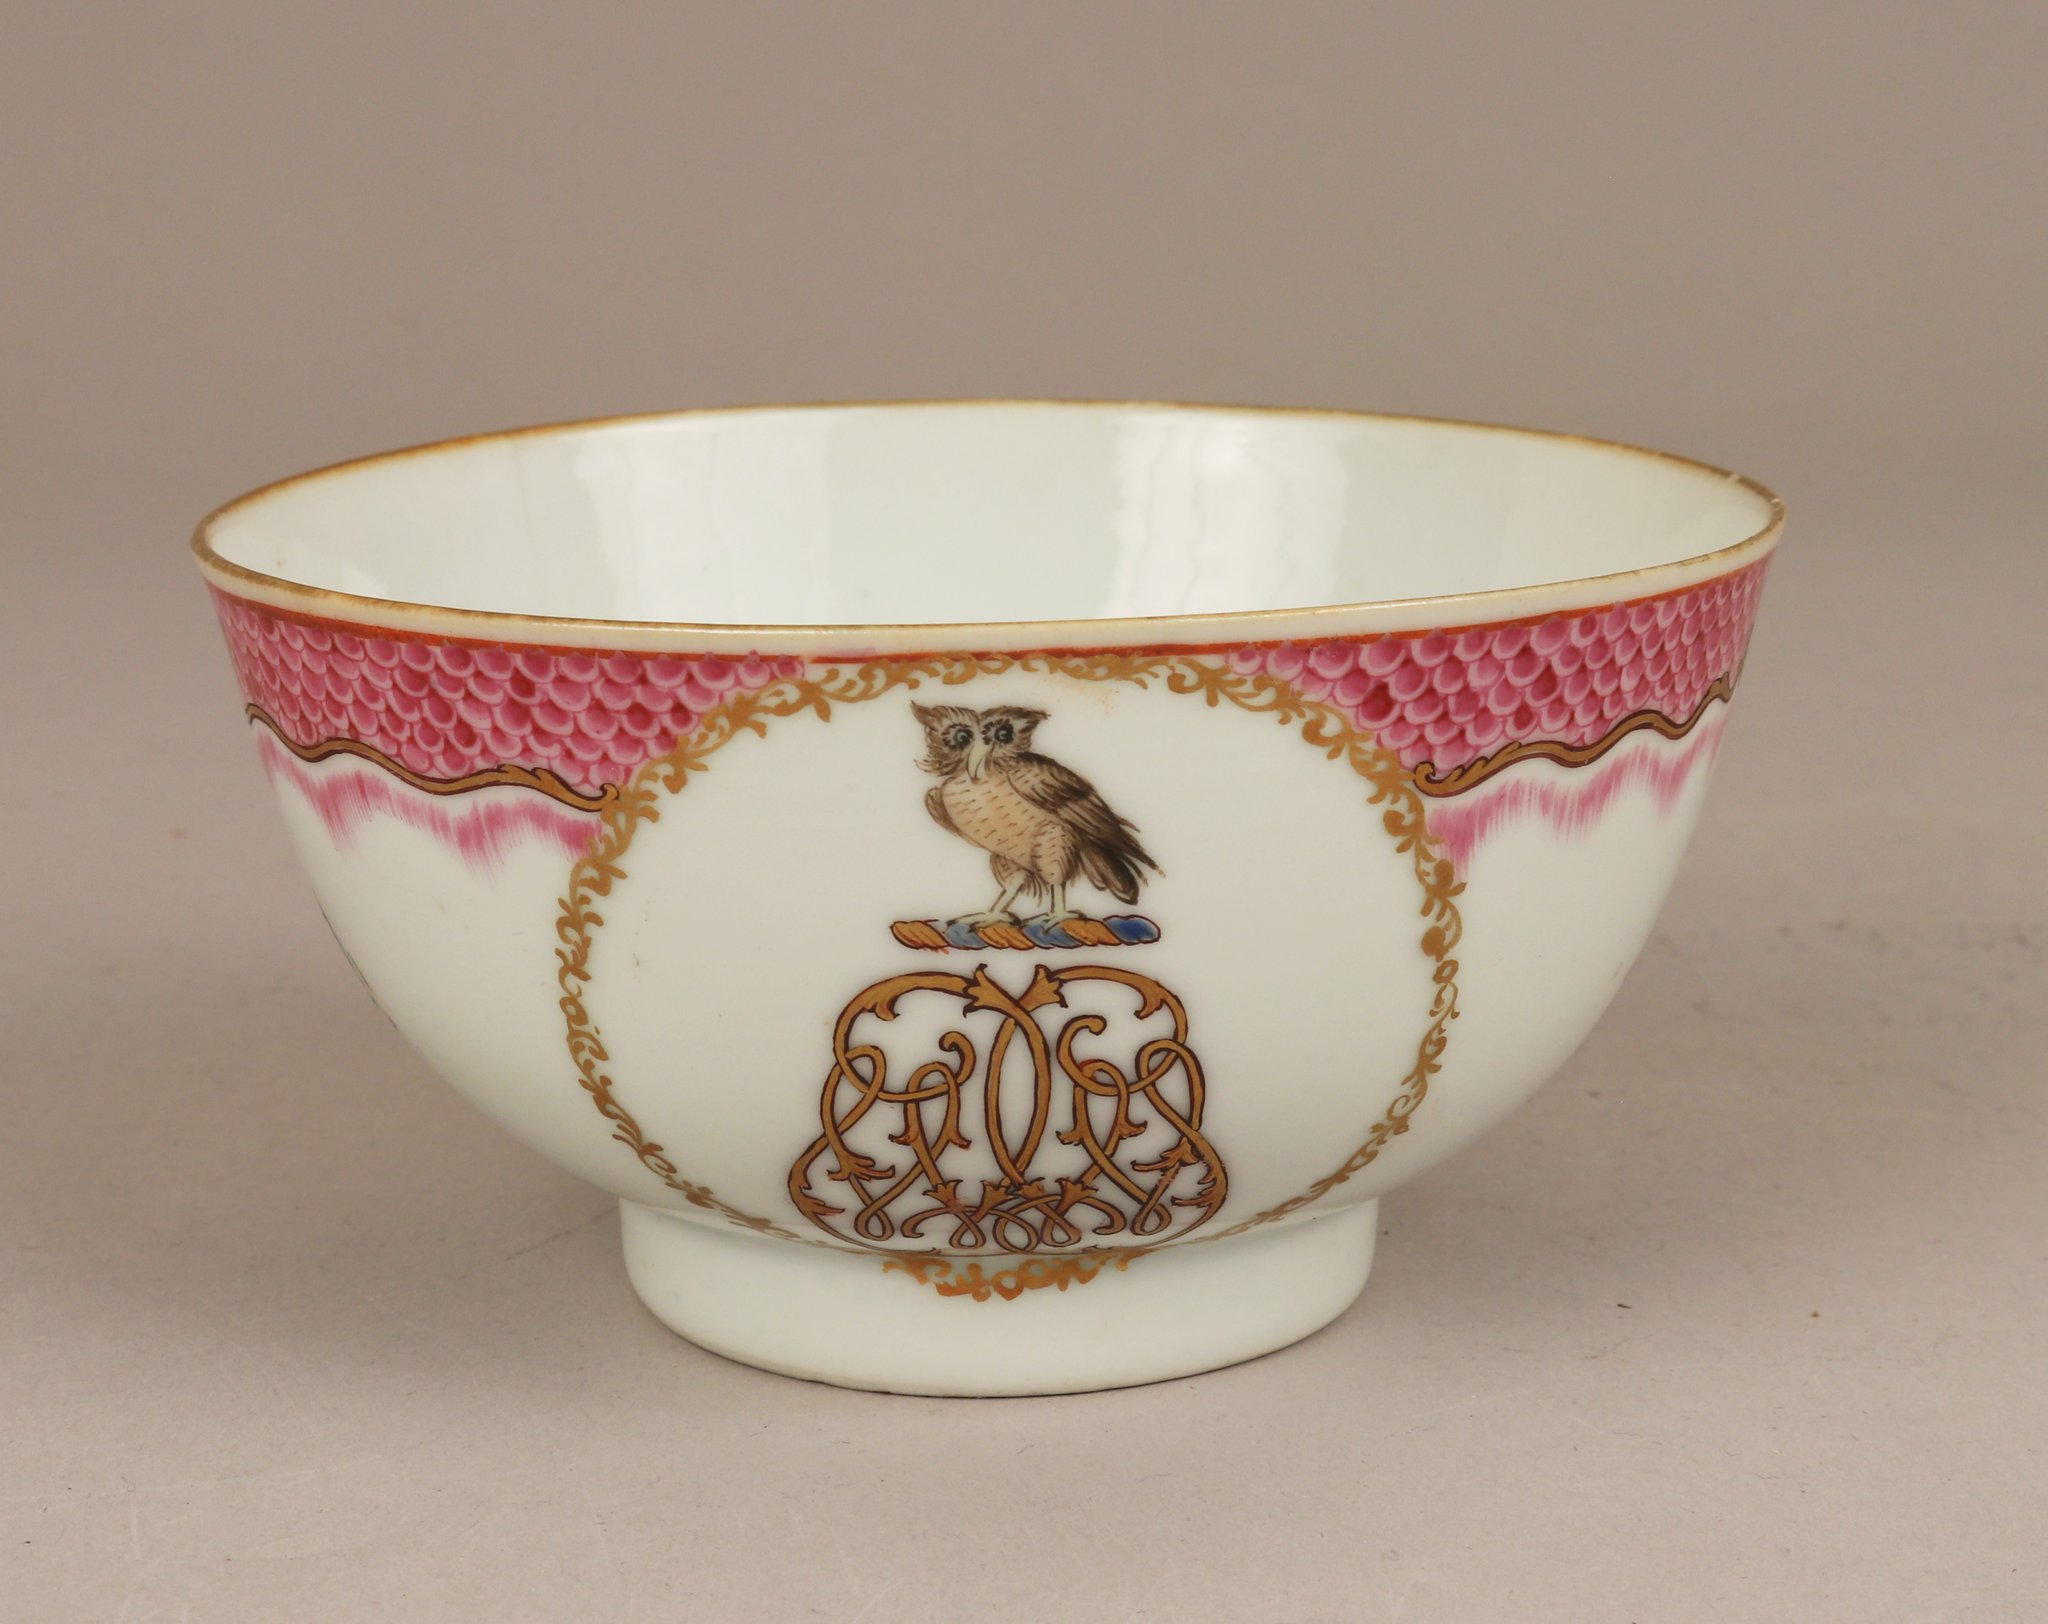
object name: bowl and stand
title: Stand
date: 1775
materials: hard paste porcelain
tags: owls,insignia